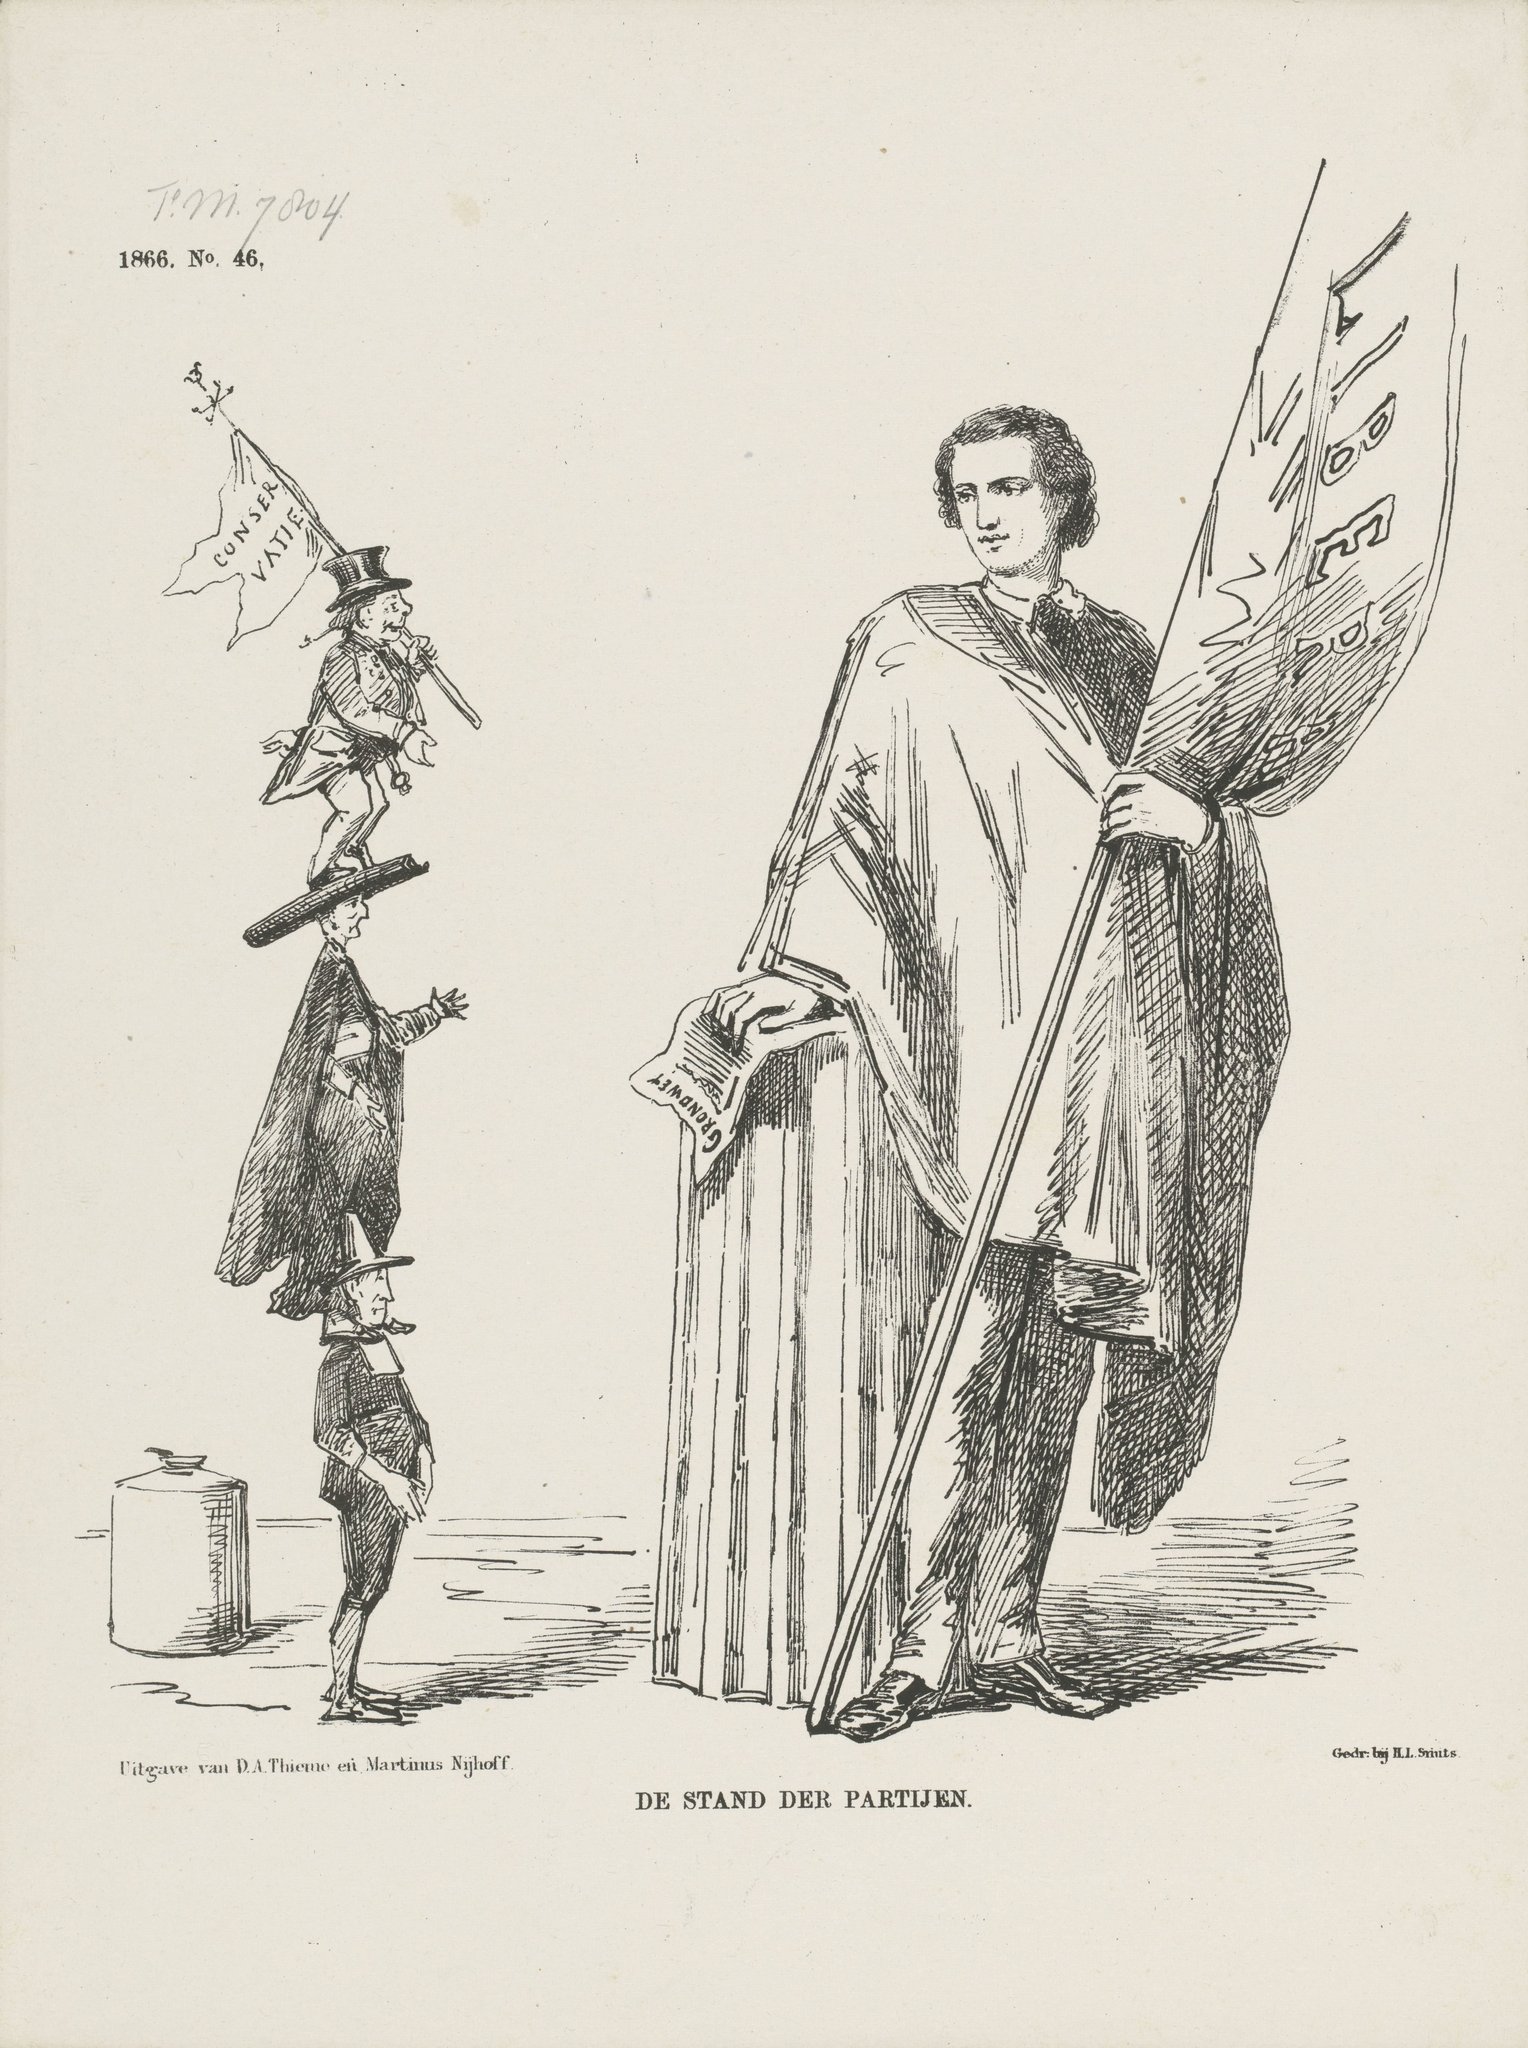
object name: print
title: Spotprent op verhouding tussen de partijen, 1866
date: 1866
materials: paper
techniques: lithograph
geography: netherlands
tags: political parties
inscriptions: collector's mark: Lugt 2228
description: Spotprent waarin het verschil in grootte tussen de liberalen en de coalitie van de andere partijen duidelijk wordt gemaakt, na de verkiezingen van 30 oktober. Plaat verschenen bij het weekblad De Nederlandsche Spectator, nr. 46, 17 november 1866.